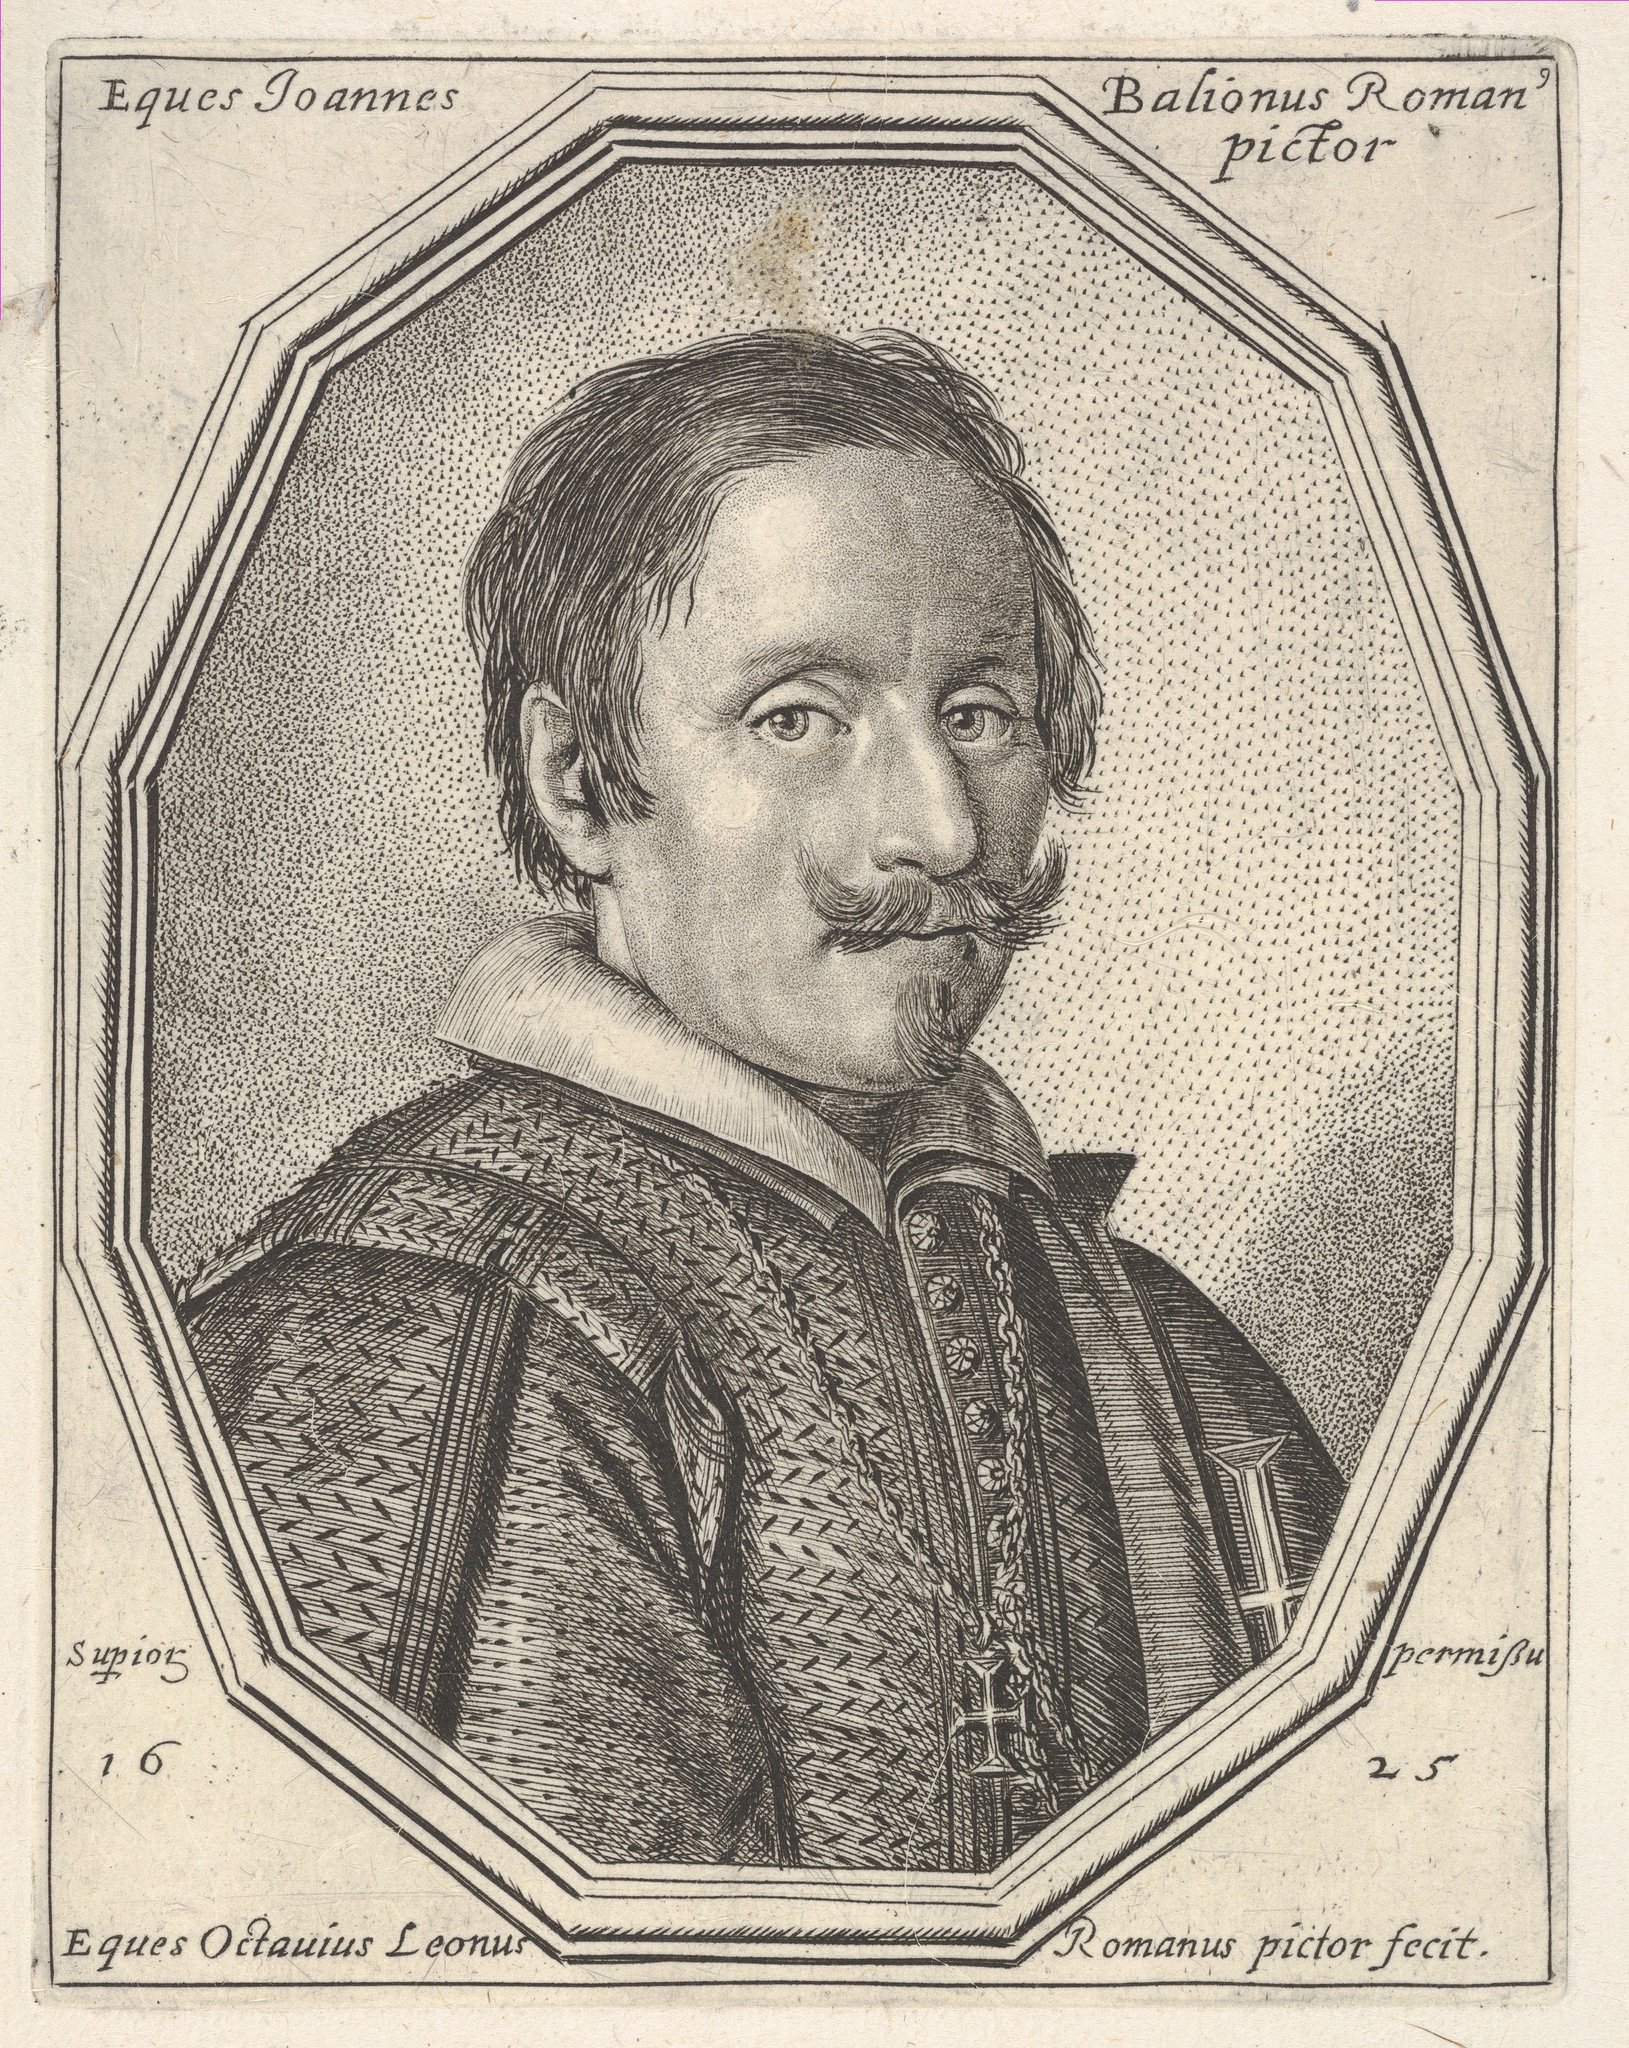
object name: print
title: Giovanni Baglione, a bust-length portrait in a twelve-sided frame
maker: ottavio leoni (il padovano)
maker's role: artist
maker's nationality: italian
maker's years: 1578-1630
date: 1625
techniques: engraving, etching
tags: men,portraits